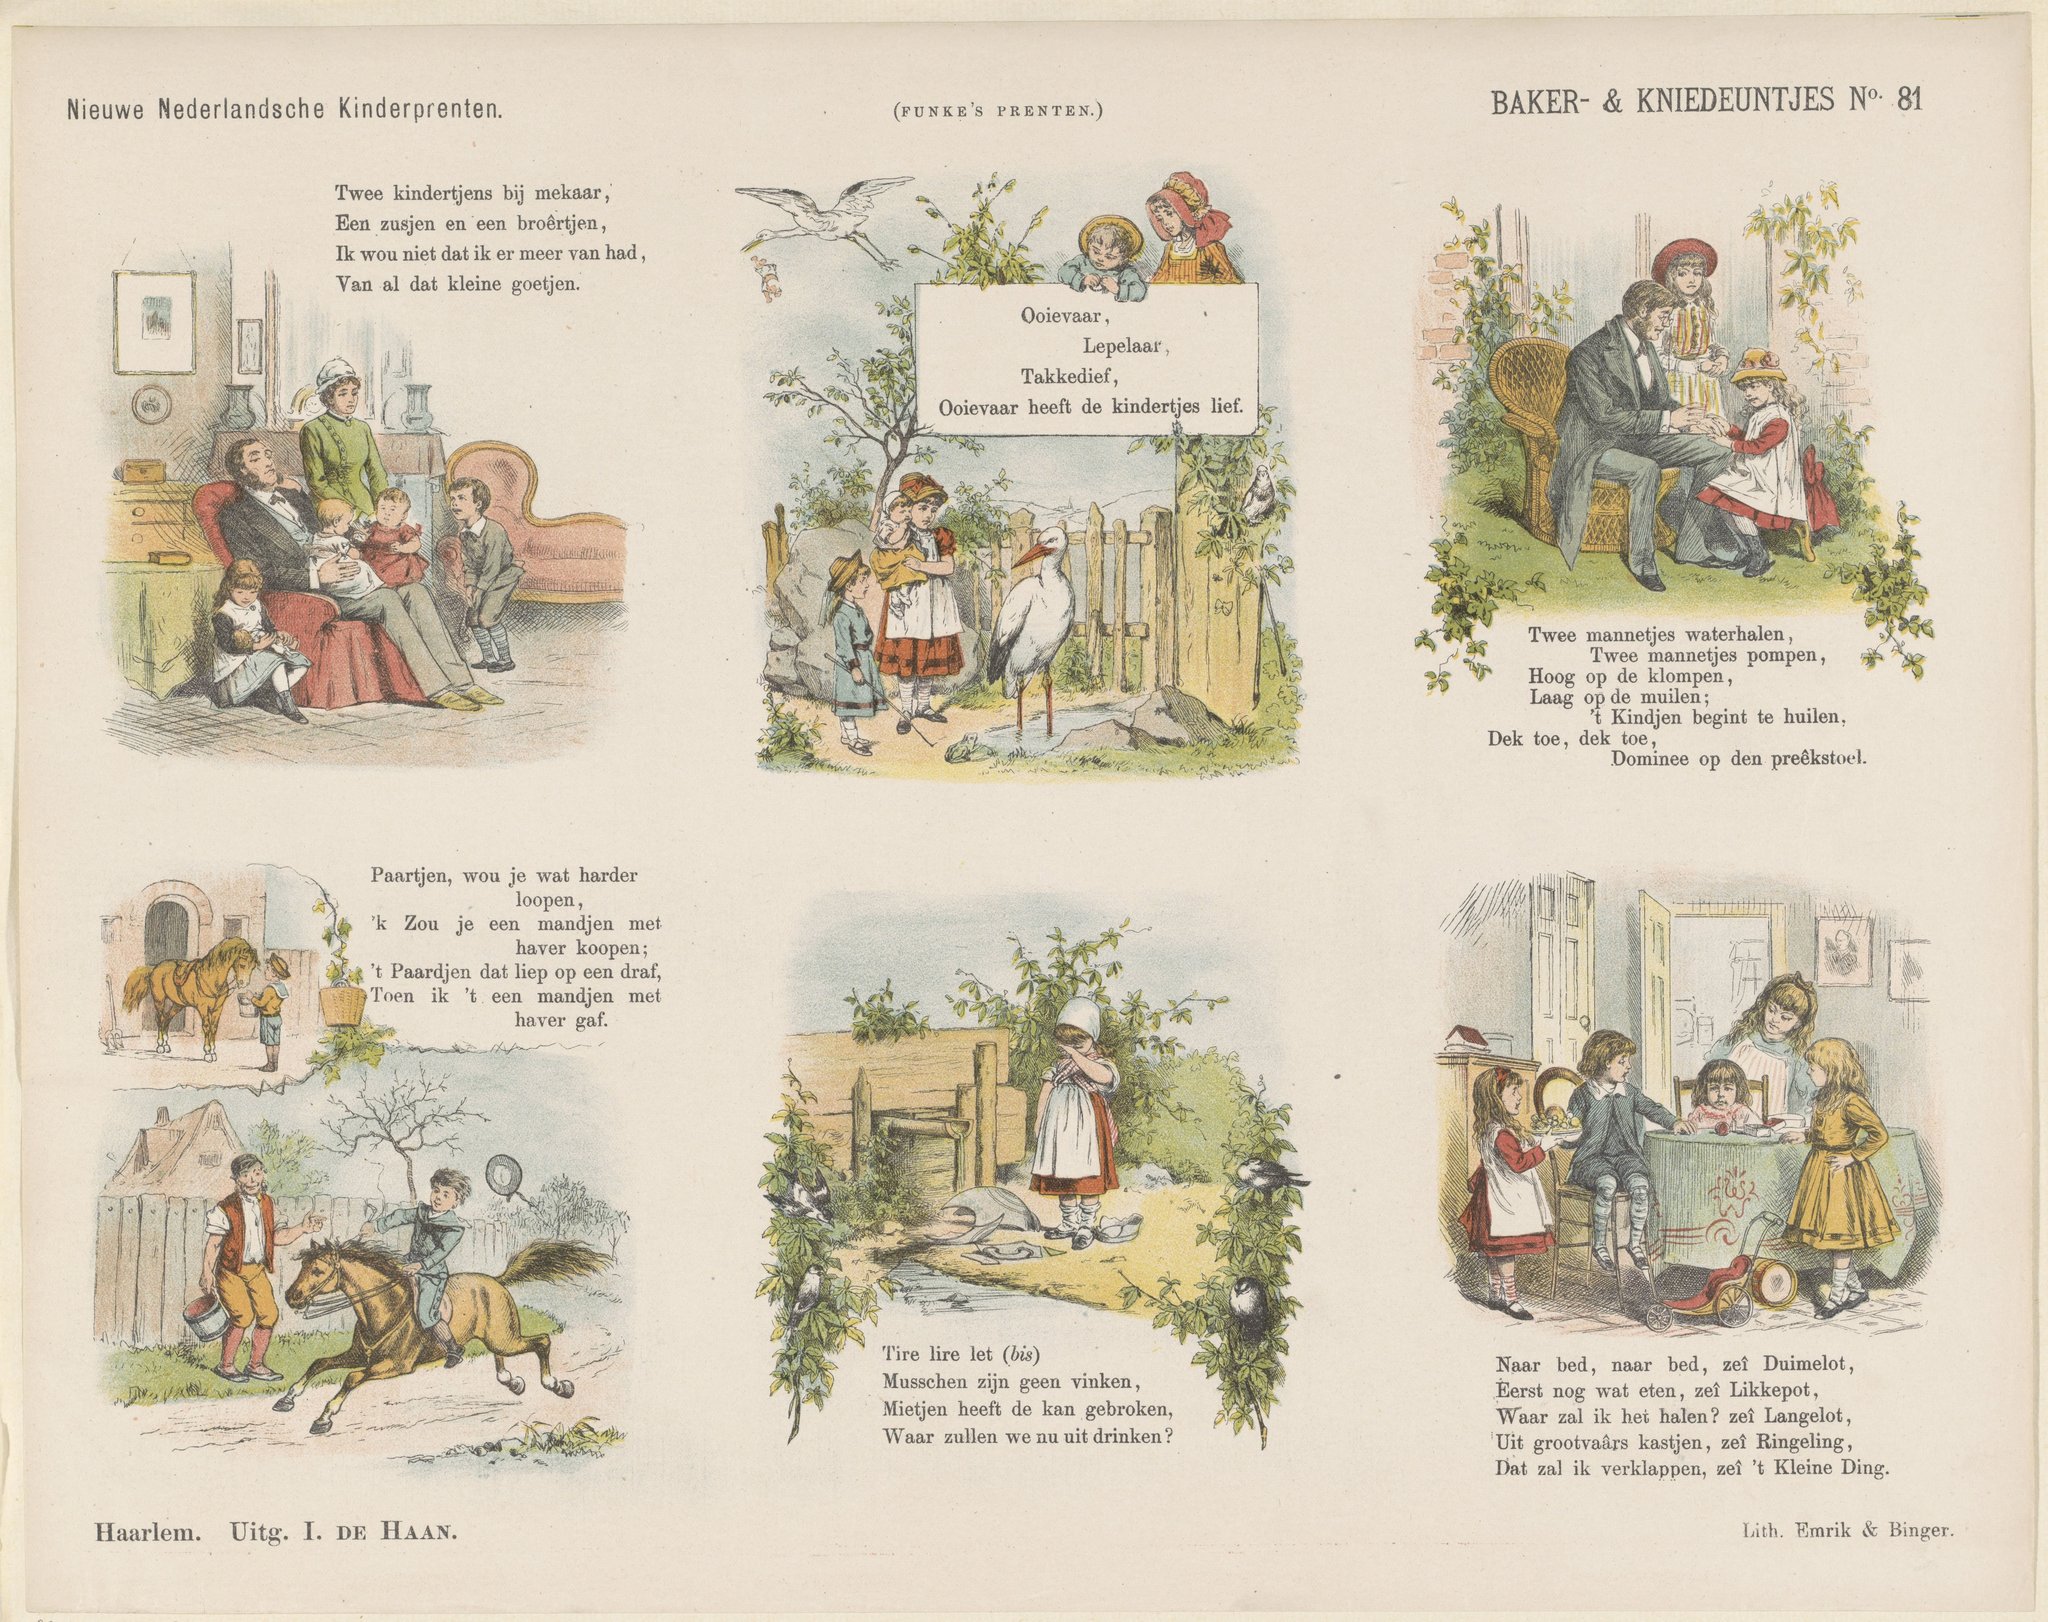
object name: popular print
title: Funke's prenten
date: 1875-1903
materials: paper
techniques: lithograph, letterpress printing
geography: haarlem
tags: riding a horse, ass, or mule; rider, horseman, animals as bringers of babies, vocal music, singing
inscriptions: collector's mark: Lugt 2760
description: Blad met 6 uitbeeldingen van kinderversjes en liedjes. Bij elke voorstelling een vers of liedtekst. Genummerd rechtsboven: No. 81.